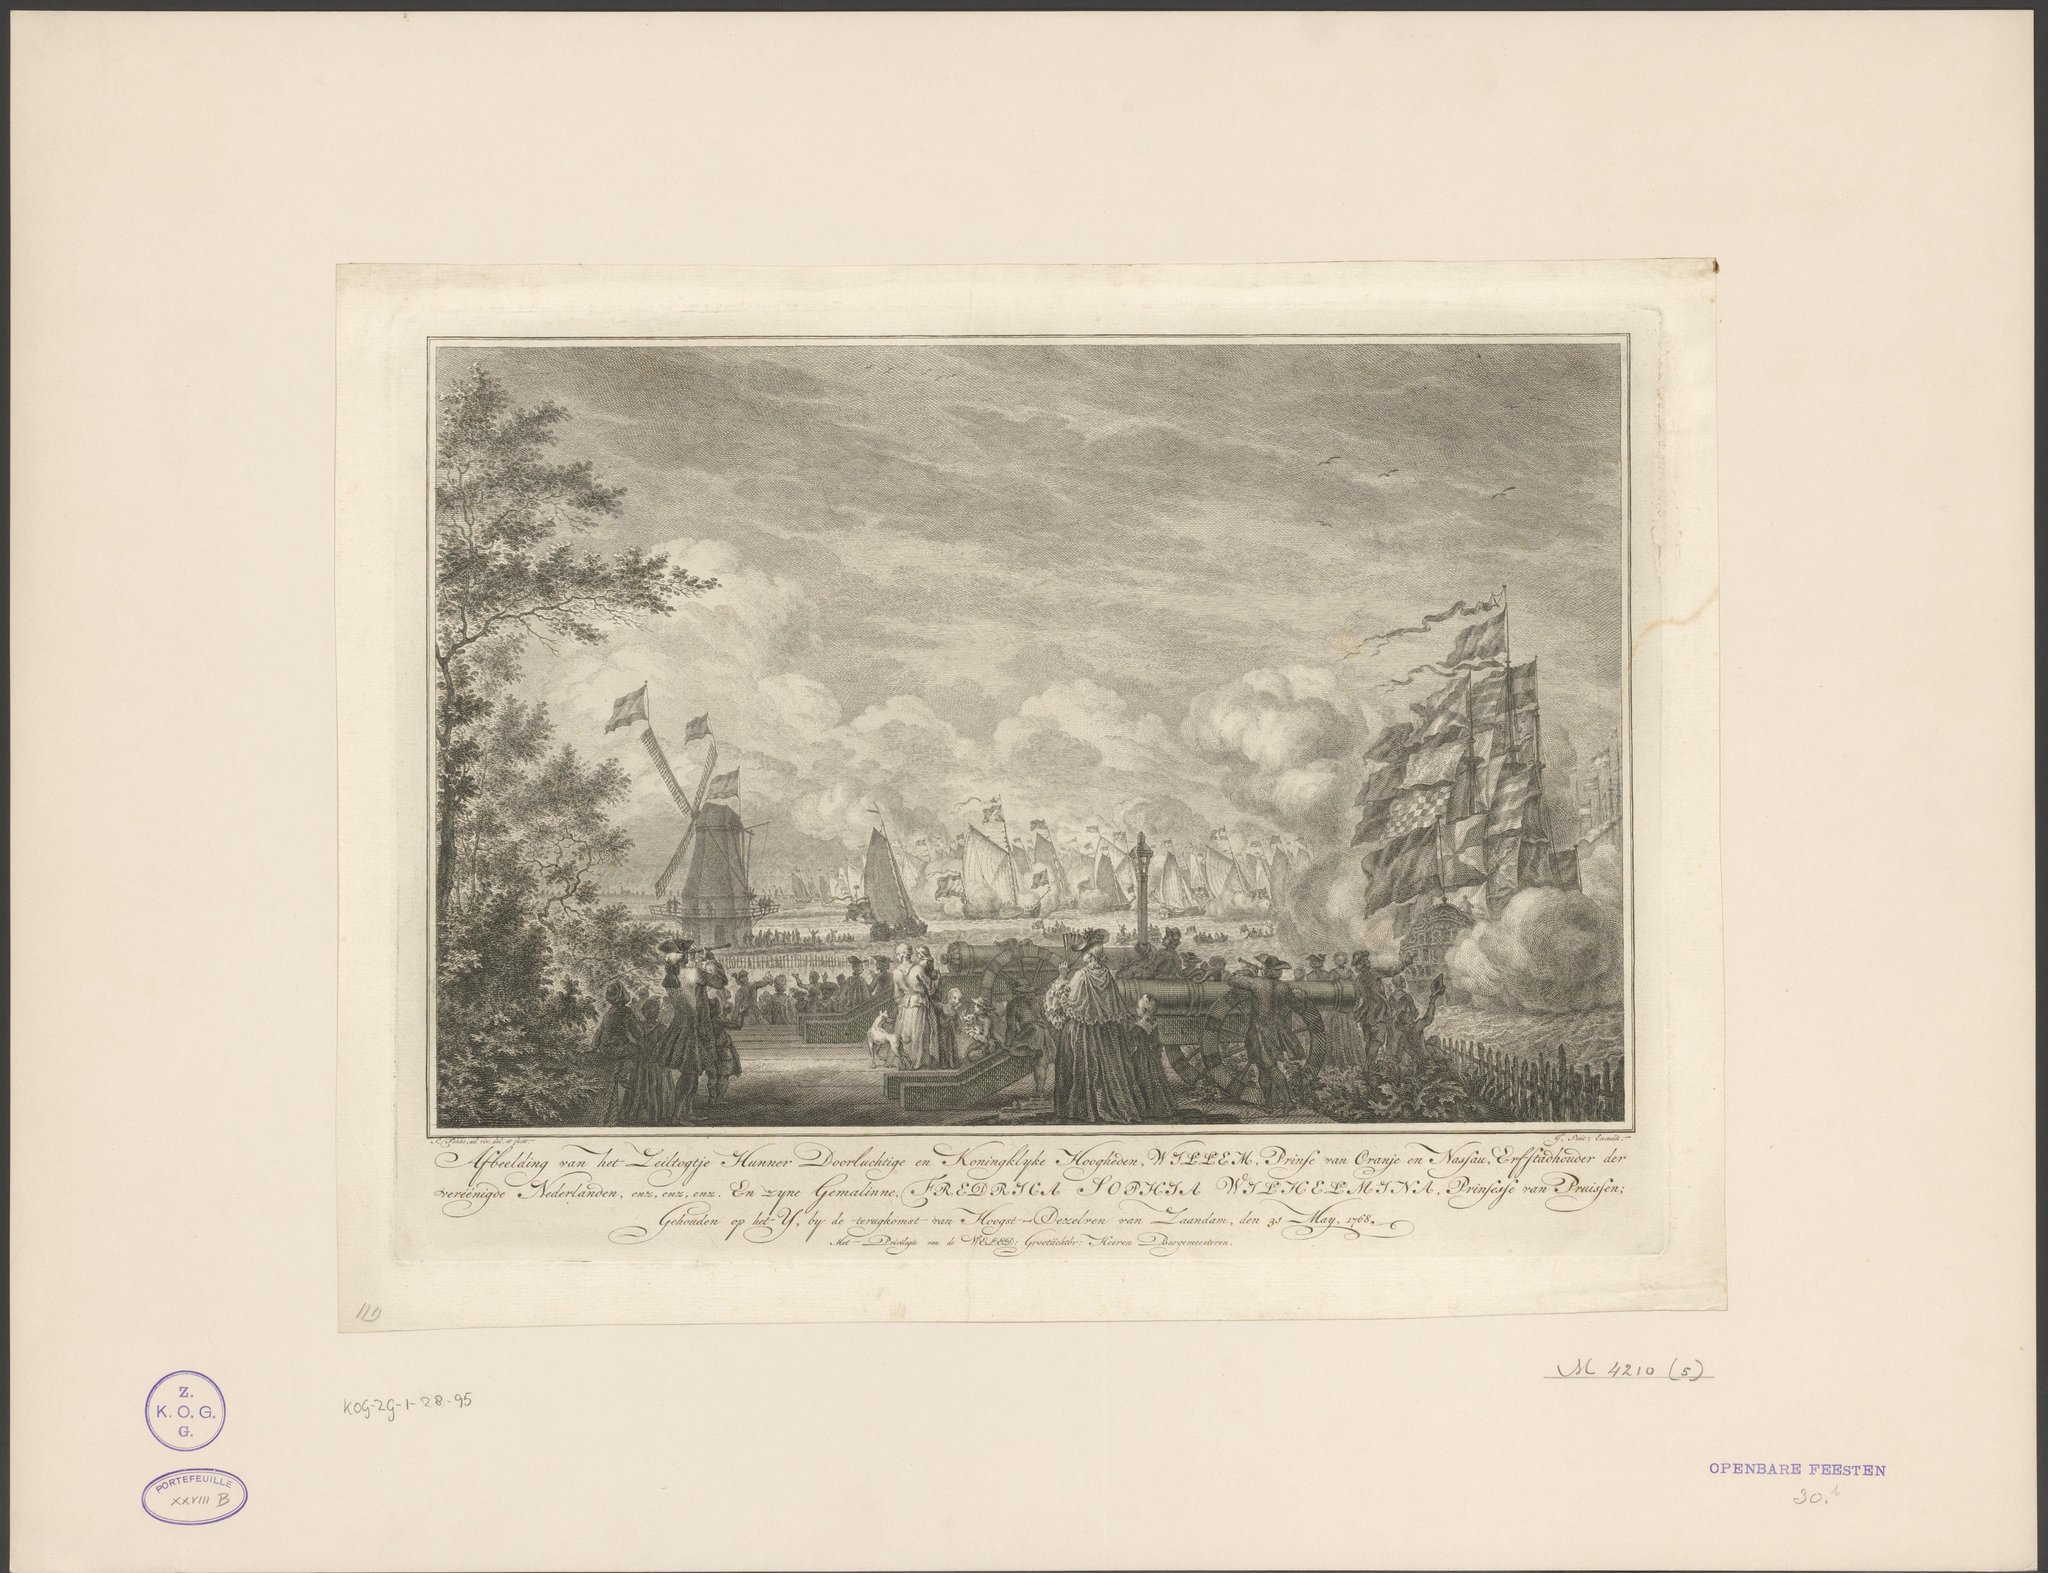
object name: print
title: Zeiltocht van Willem V en Wilhelmina van Pruisen op het IJ, 1768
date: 1772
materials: paper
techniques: engraving, etching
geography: amsterdam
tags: the hague, william v (prince of orange), berlin, painter, draughtsman, wilhelmina of prussia (princess of orange), public festivities on the occasion of royal events - aa - festivities on the water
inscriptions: collector's mark: Lugt 1641, stamp, stamp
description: Zeiltocht van stadhouder Willem V en prinses Wilhelmina van Pruisen op het IJ bij terugkomst uit Zaandam, 31 mei 1768. Gezicht op de vele schepen op het water, met toeschouwers bij kanonnen op de kade. Links een molen. Onderwerpsrubrieken binnen de Atlas Zeden en Gewoonten: Zeden en Gewoonten in Engeren Zin. Volksleven. Openbare feesten. Vorstelijke intochten, (Illuminaties, vuurwerken en dergelijke, openbare feesten).